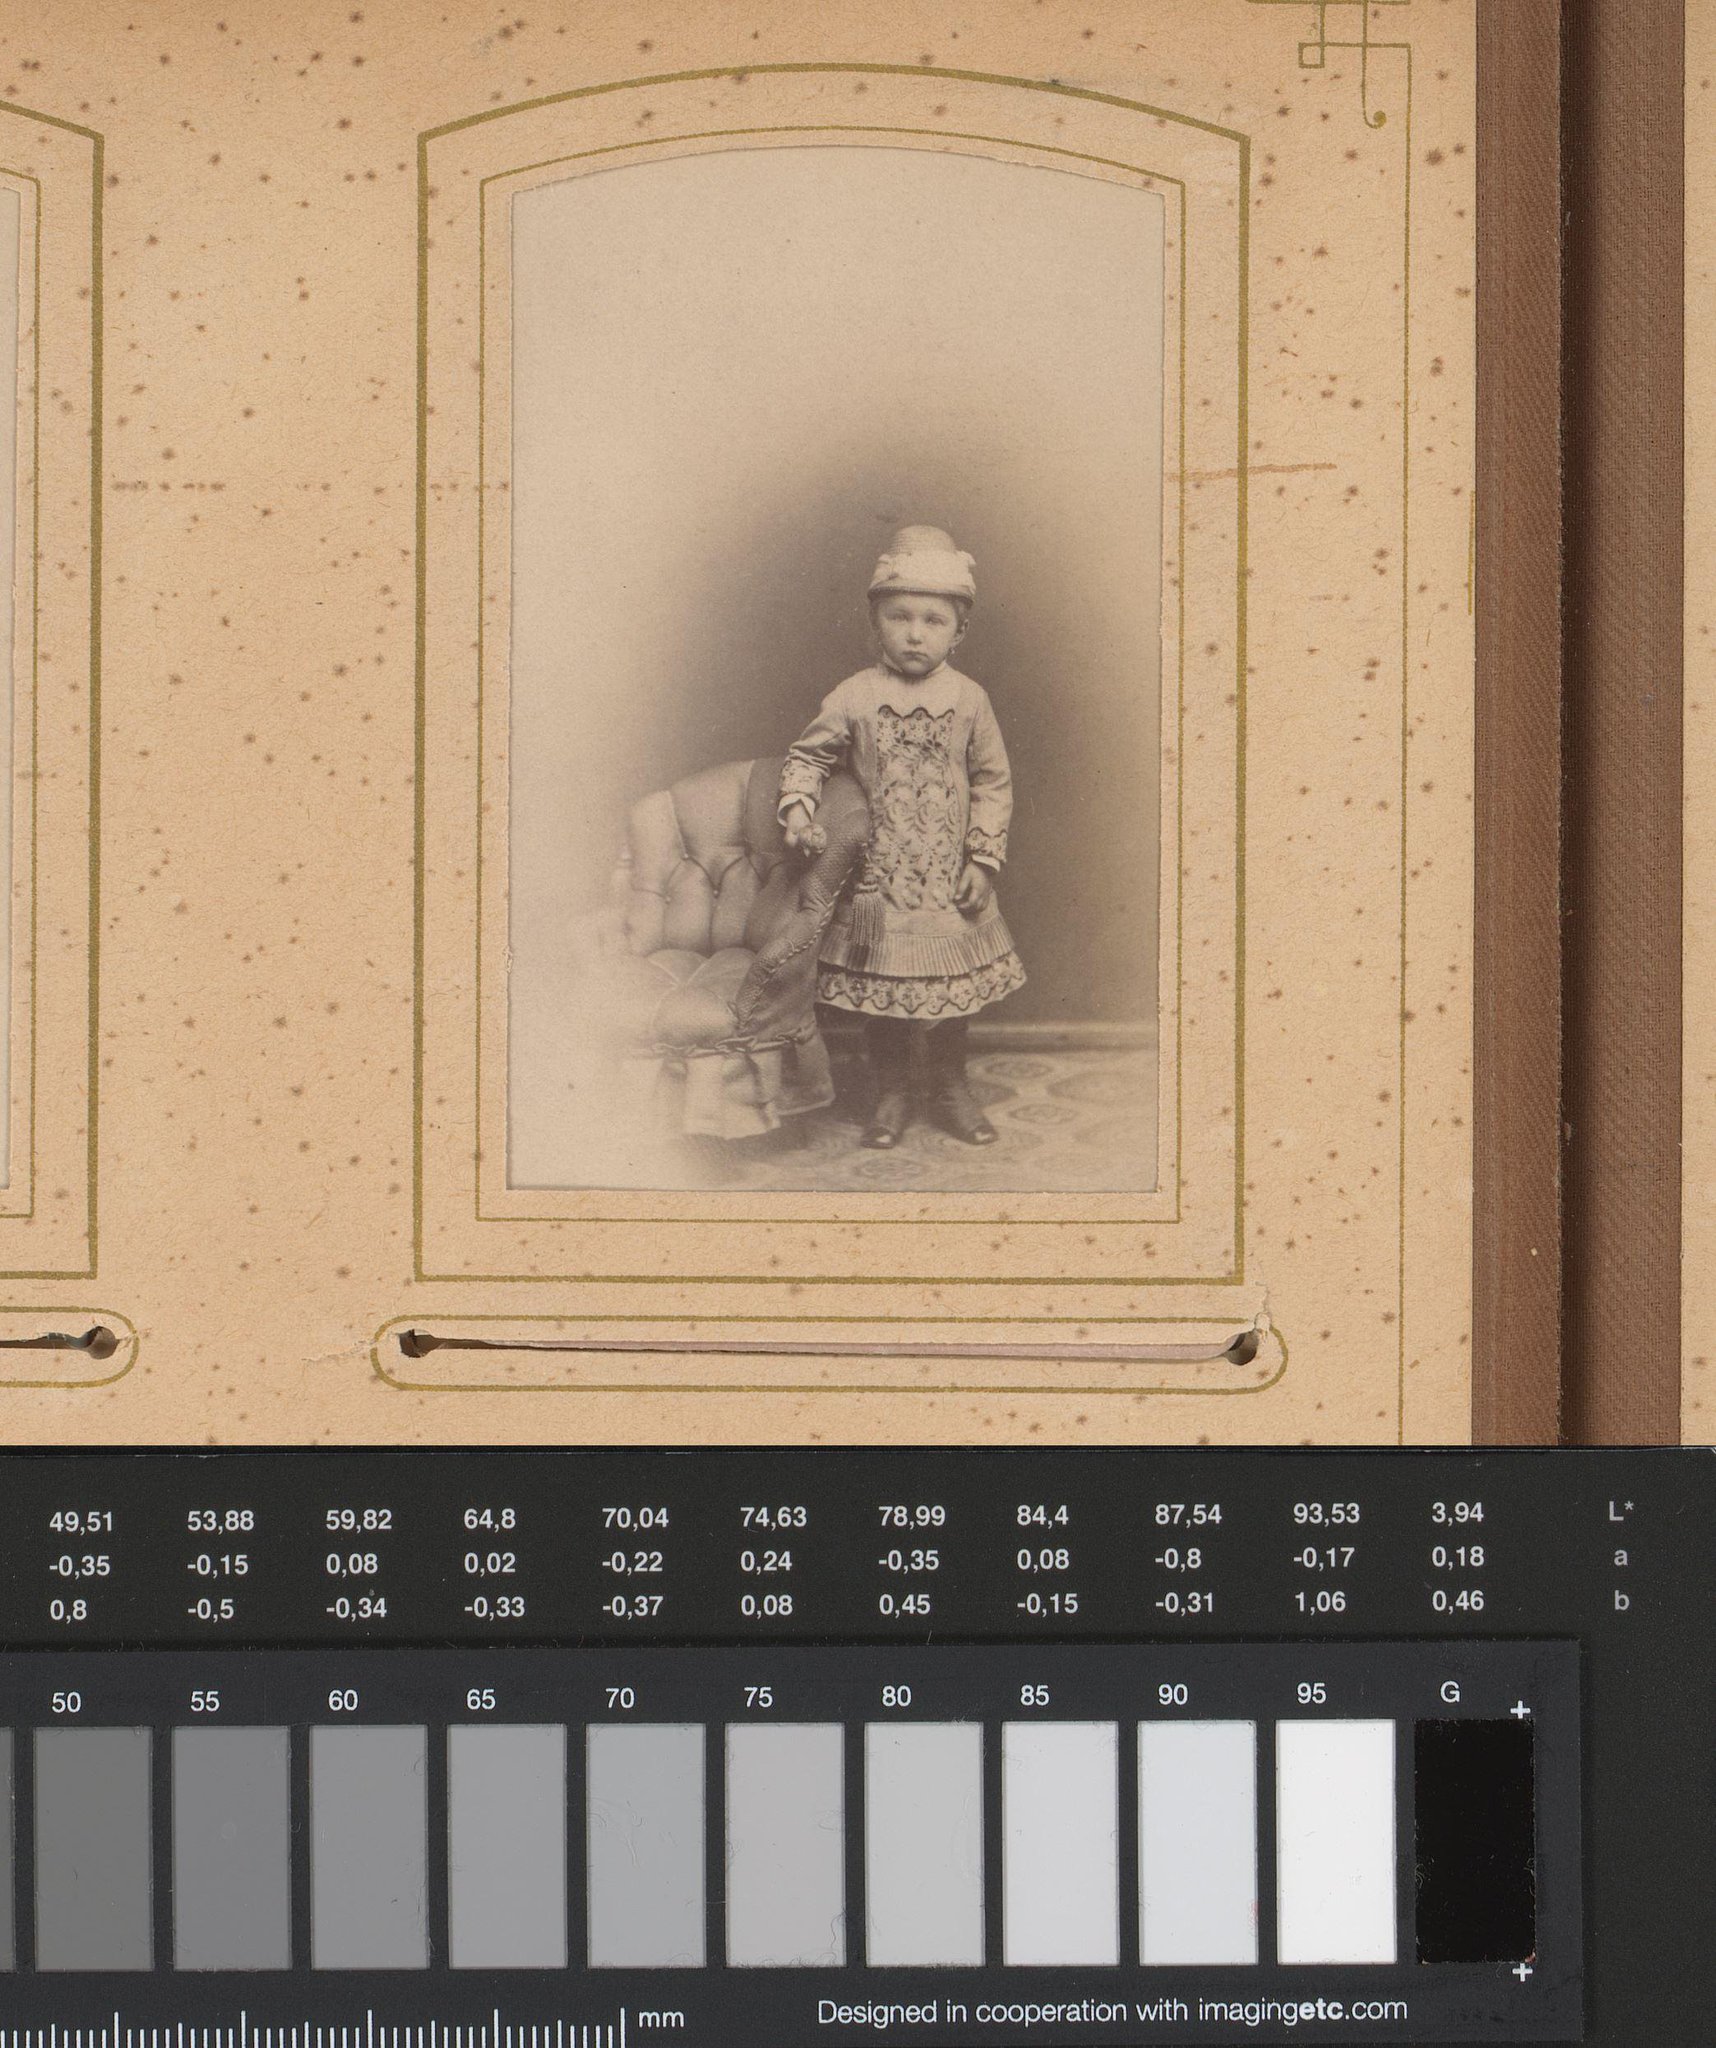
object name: album leaf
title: Portret van een meisje met hoed, staand bij een stoel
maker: r. schneider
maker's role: fotograaf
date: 1860-1900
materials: cardboard, photographic support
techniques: albumen print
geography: meerane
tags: historical persons - bb - woman, head-gear: hat, toddler (female), chair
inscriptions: inscription: ‘R. Schneider/ Photographie u. Colorir-Anstalt/ Meerane/ Die Platten werden zu Nachbestellungen aufbewahrt.’